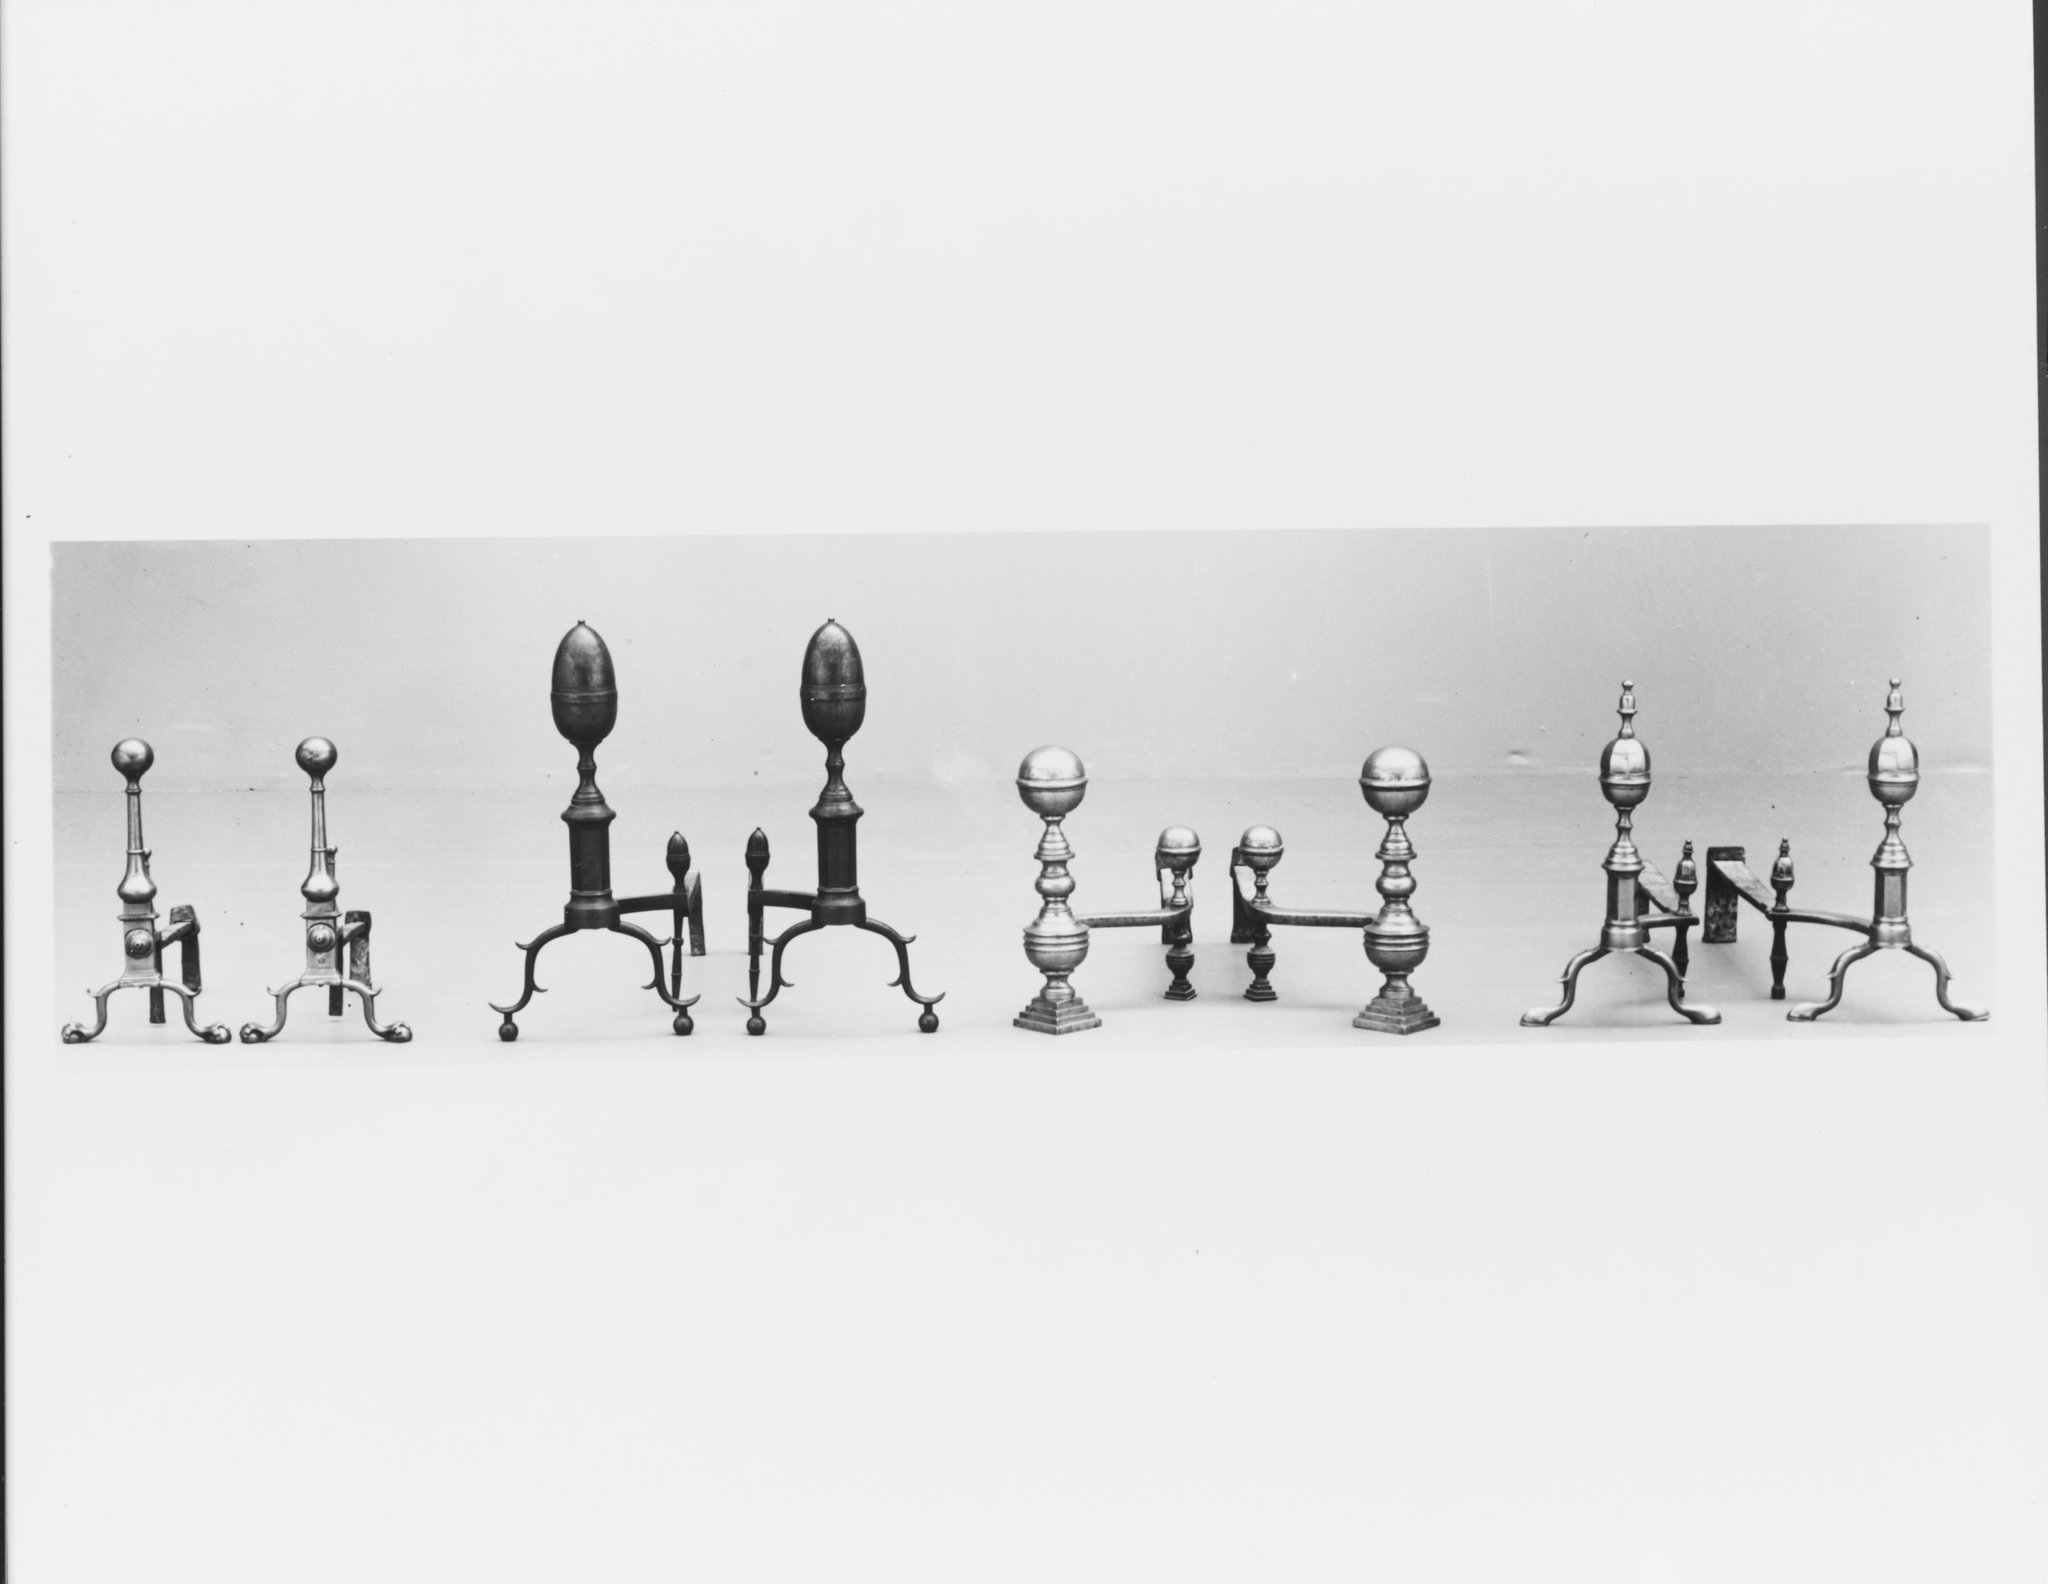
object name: andiron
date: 1800-1830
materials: metal